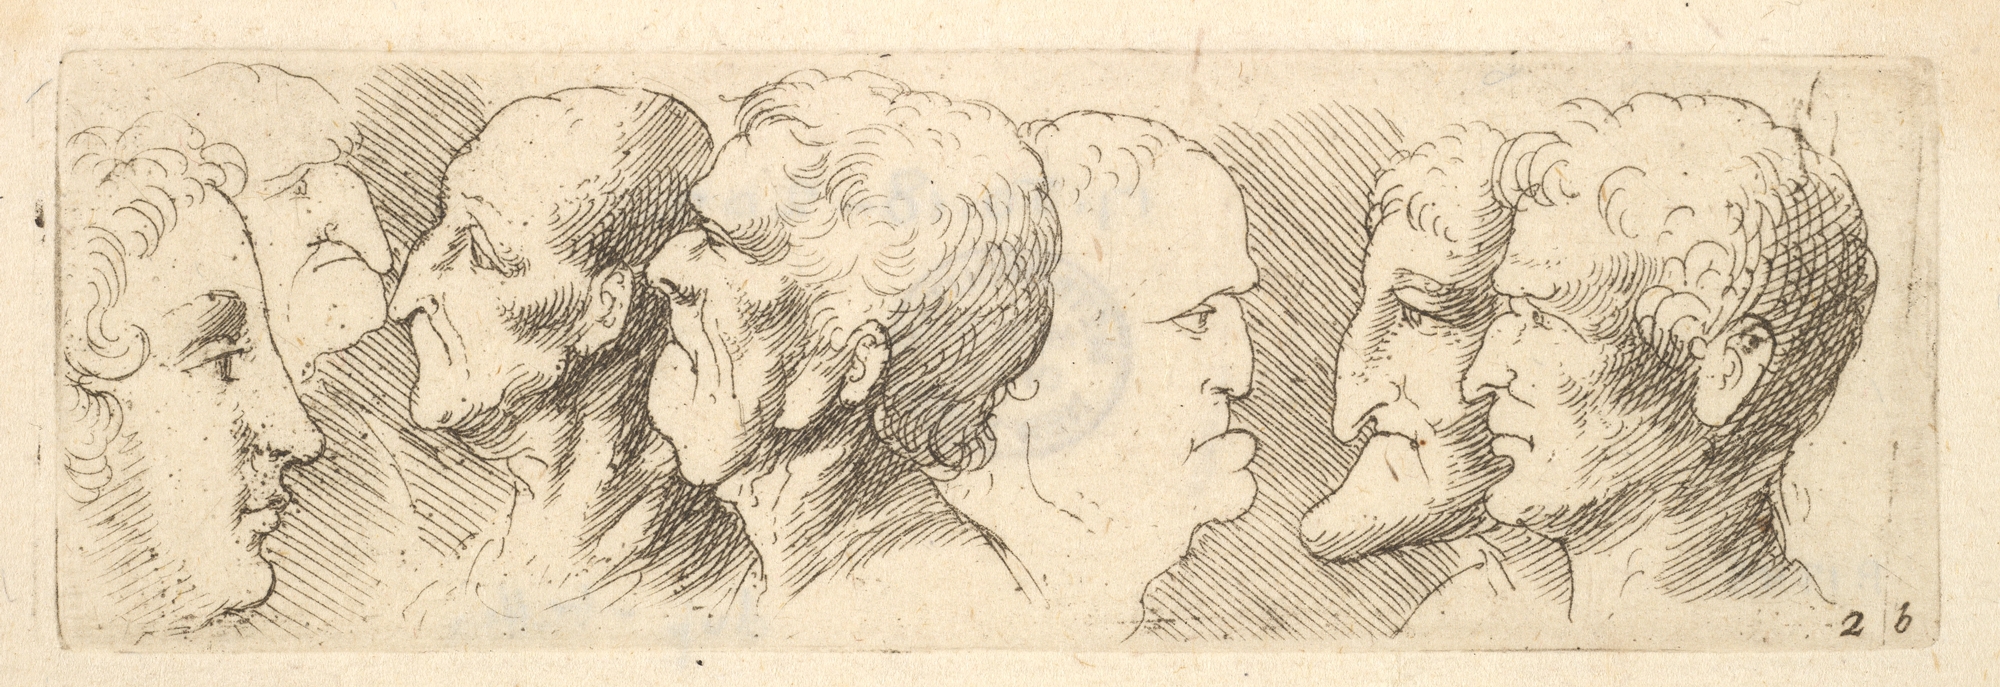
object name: print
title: Head studies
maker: wenceslaus hollar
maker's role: artist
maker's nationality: bohemian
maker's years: 1607-1677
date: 1645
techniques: etching, printing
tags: heads,men